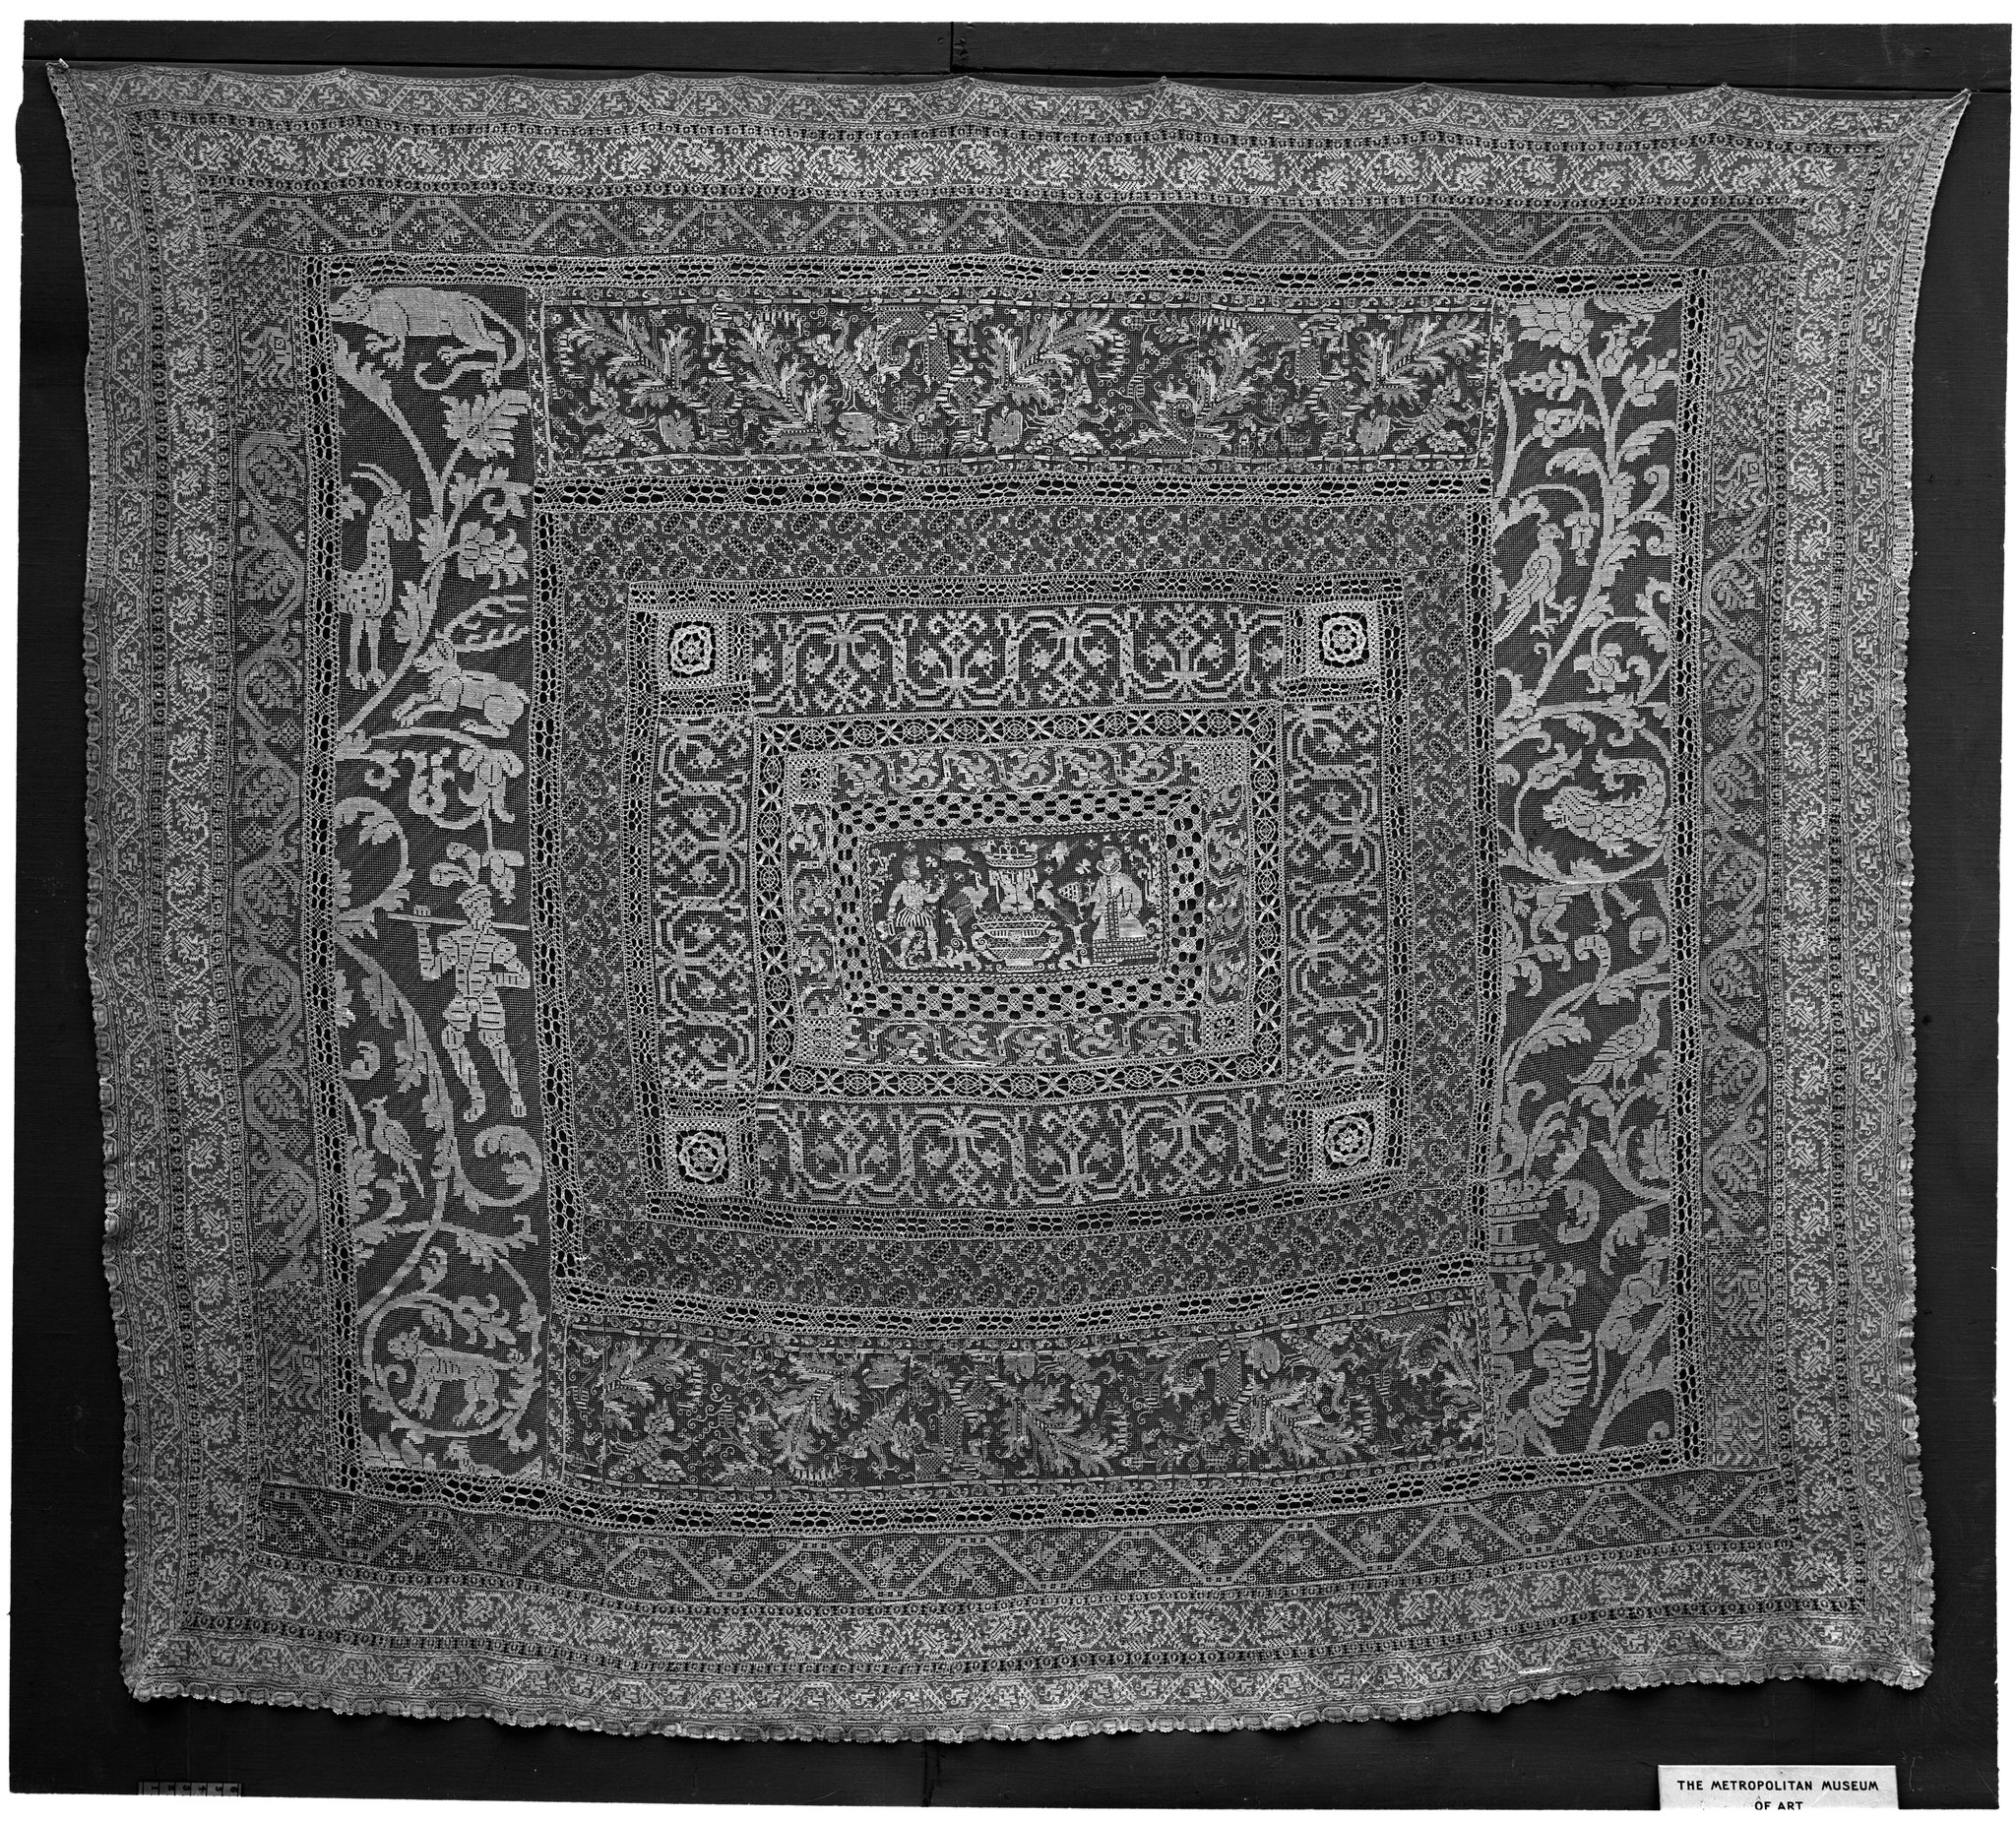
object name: spread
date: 1501-1700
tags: animals,birds,men